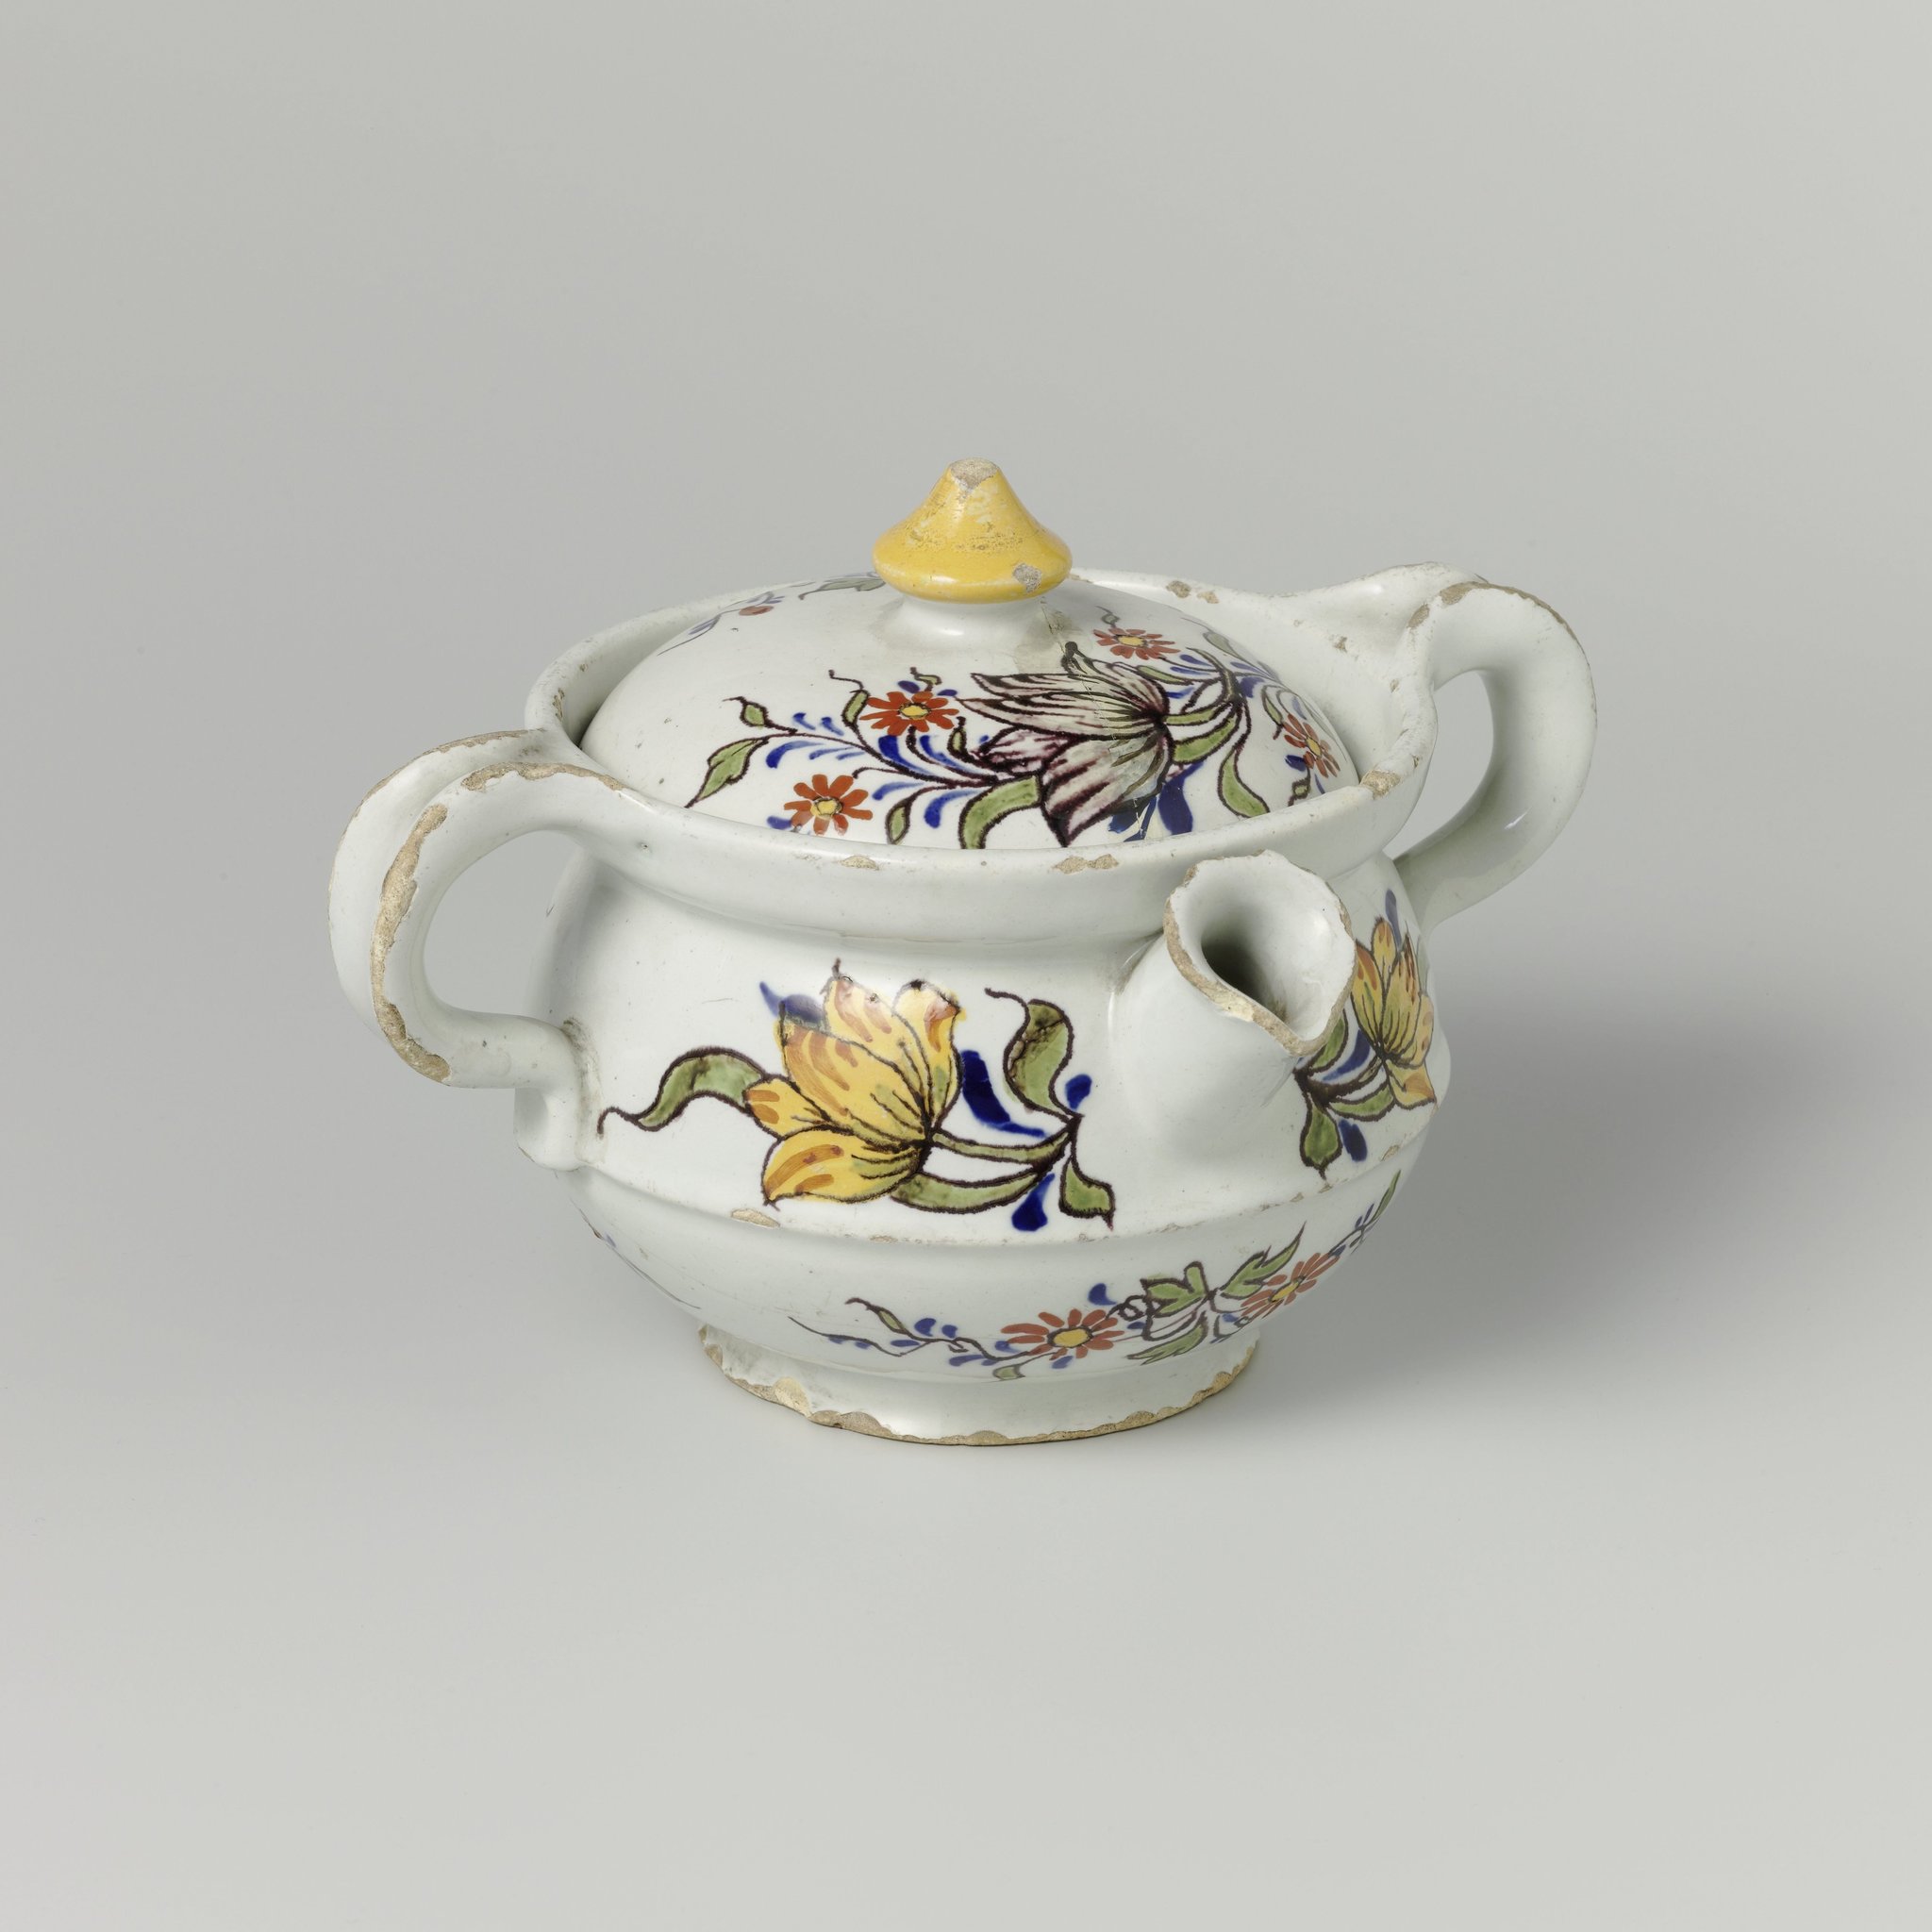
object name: pot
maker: Anonymous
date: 1770-1800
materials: faience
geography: delft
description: Pot van faience met 2 oren en een tuit. Veelkleurig beschilderd.